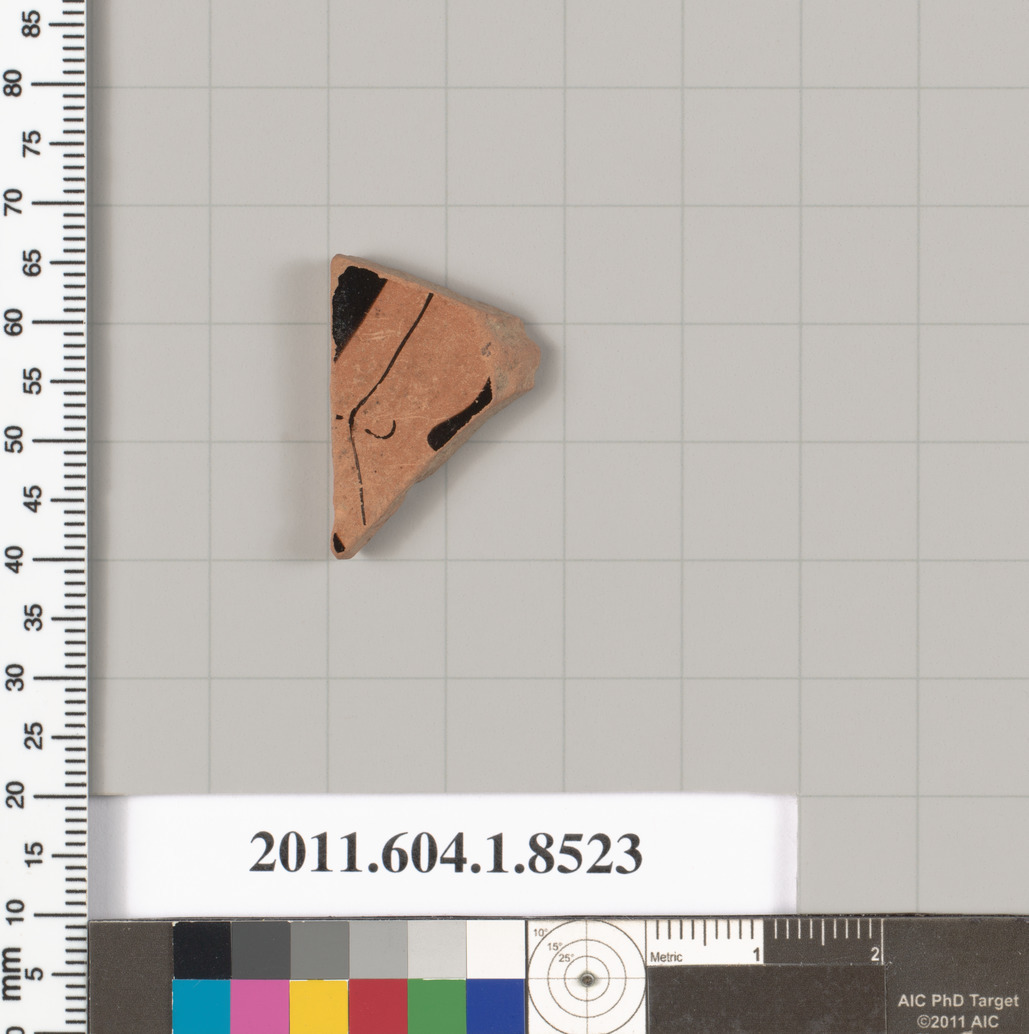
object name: kylix fragment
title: Terracotta fragment of a stemless kylix (drinking cup)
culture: greek, attic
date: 475-451 BCE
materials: terracotta